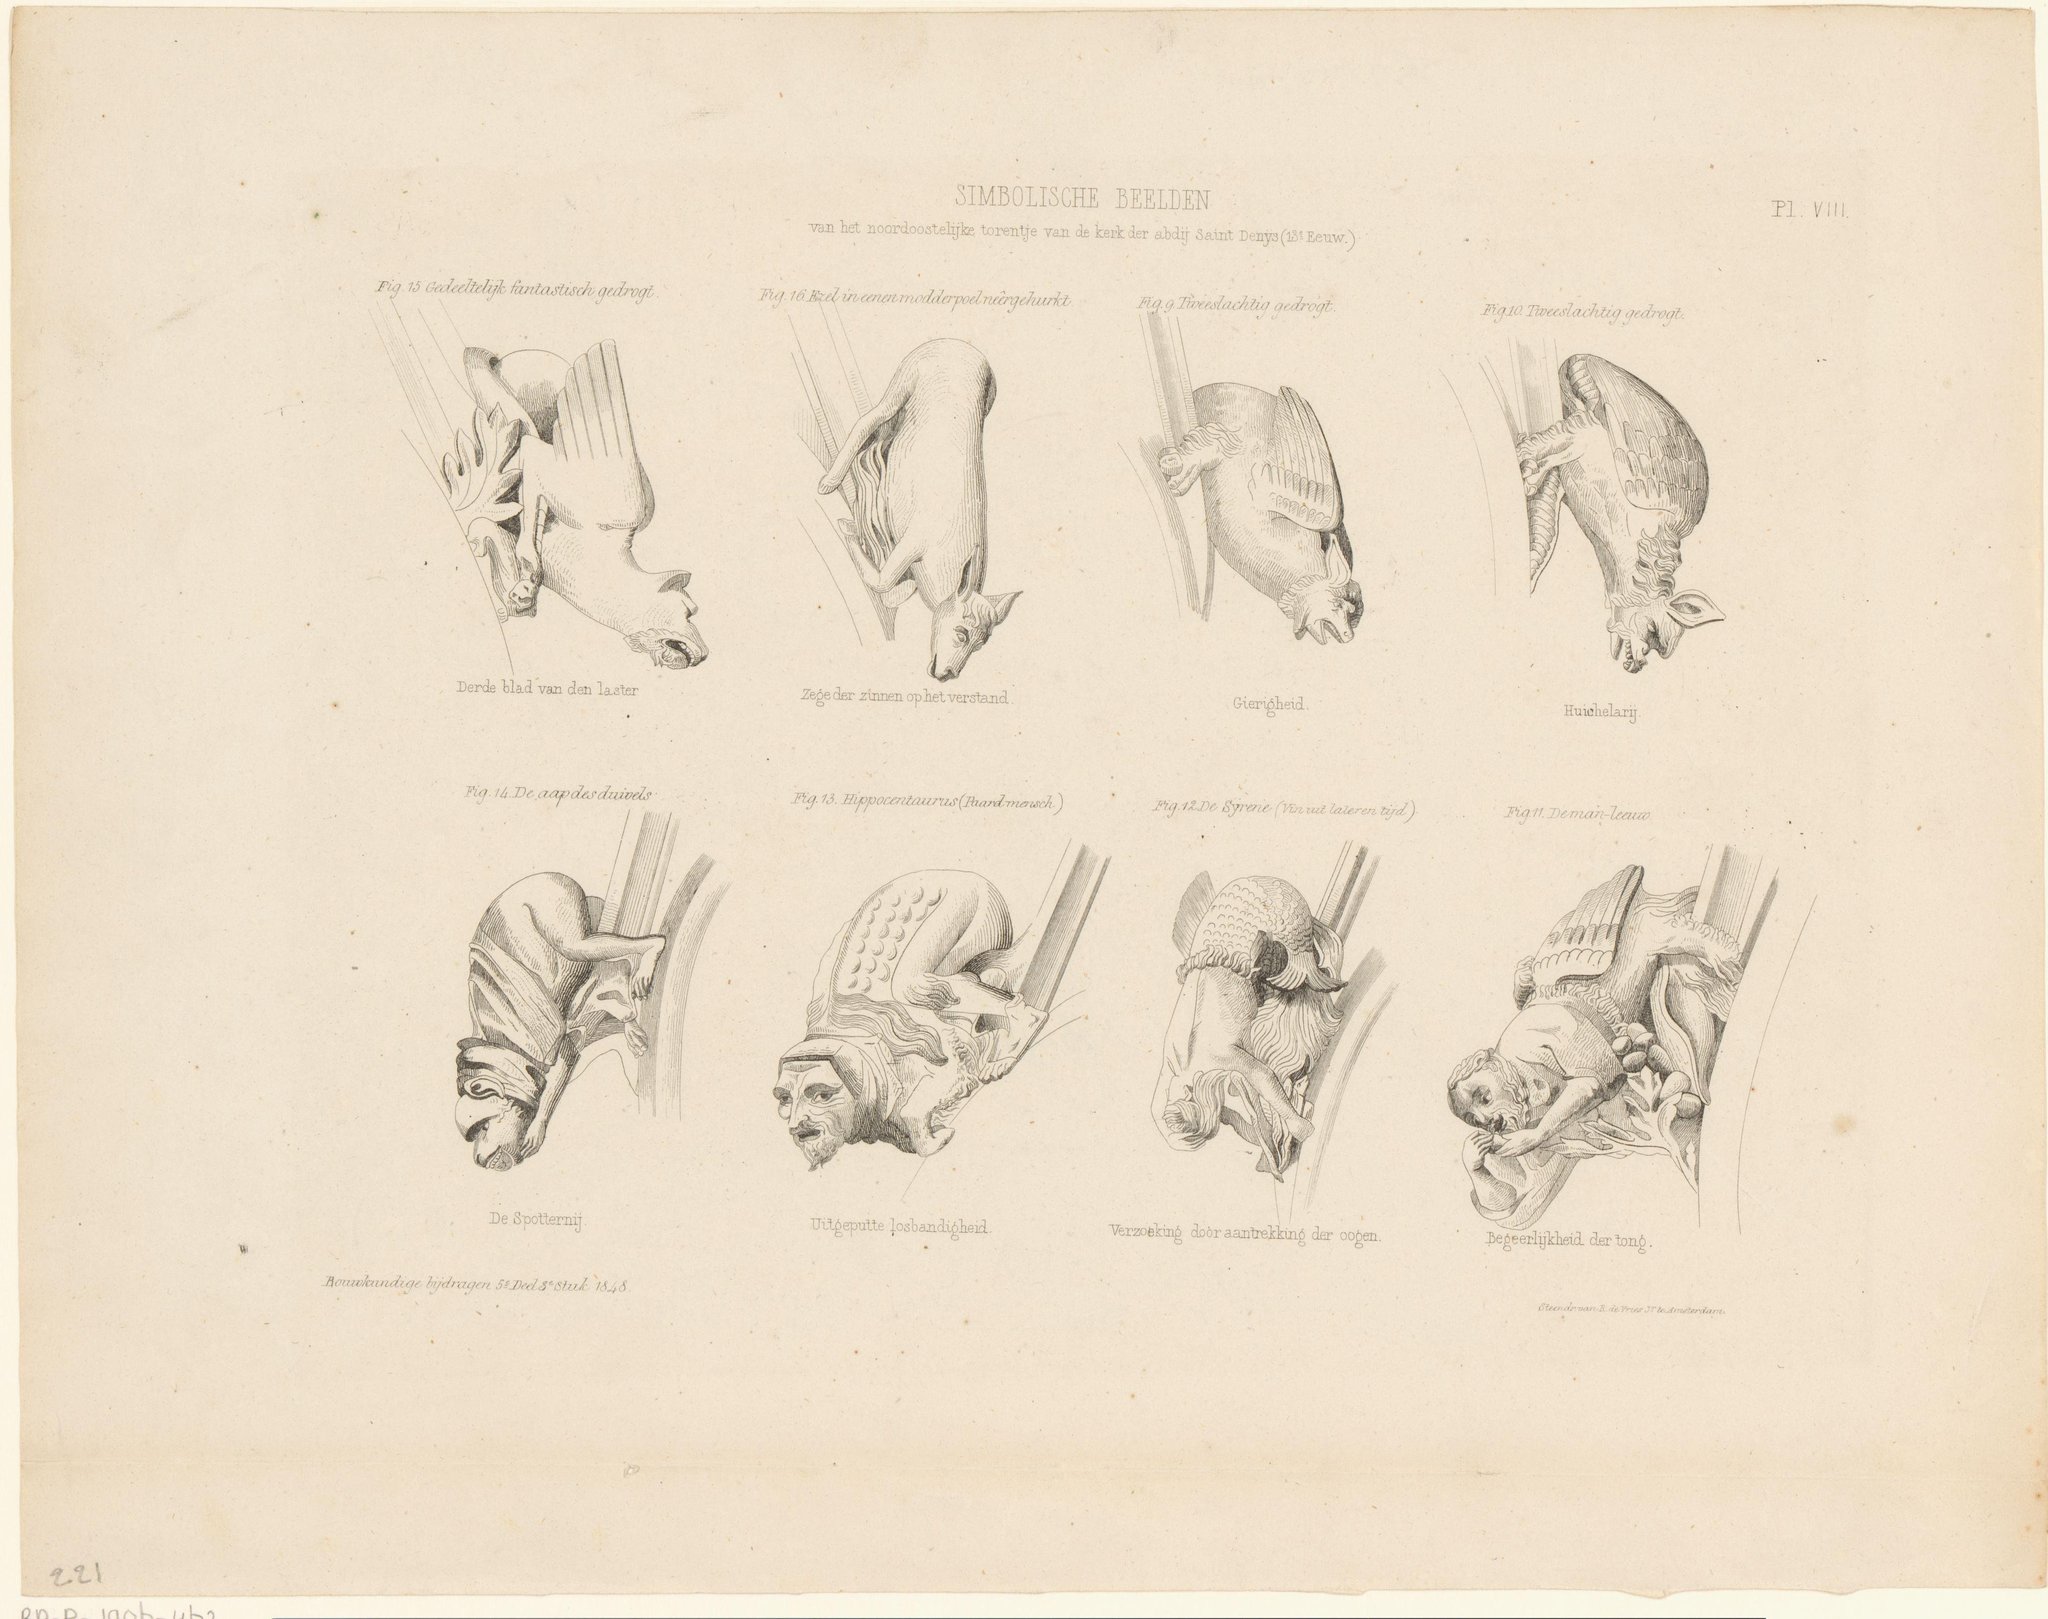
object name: book illustration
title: Acht waterspuwers op de noordelijke toren van de abdij van Saint-Denis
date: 1848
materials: paper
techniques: lithograph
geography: amsterdam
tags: ornament ~ grotesque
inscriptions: collector's mark: Lugt 2228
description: Prent uit: S.n. Bouwkundige bijdragen. Amsterdam: Bakkenes & Co, L. van, 1849.